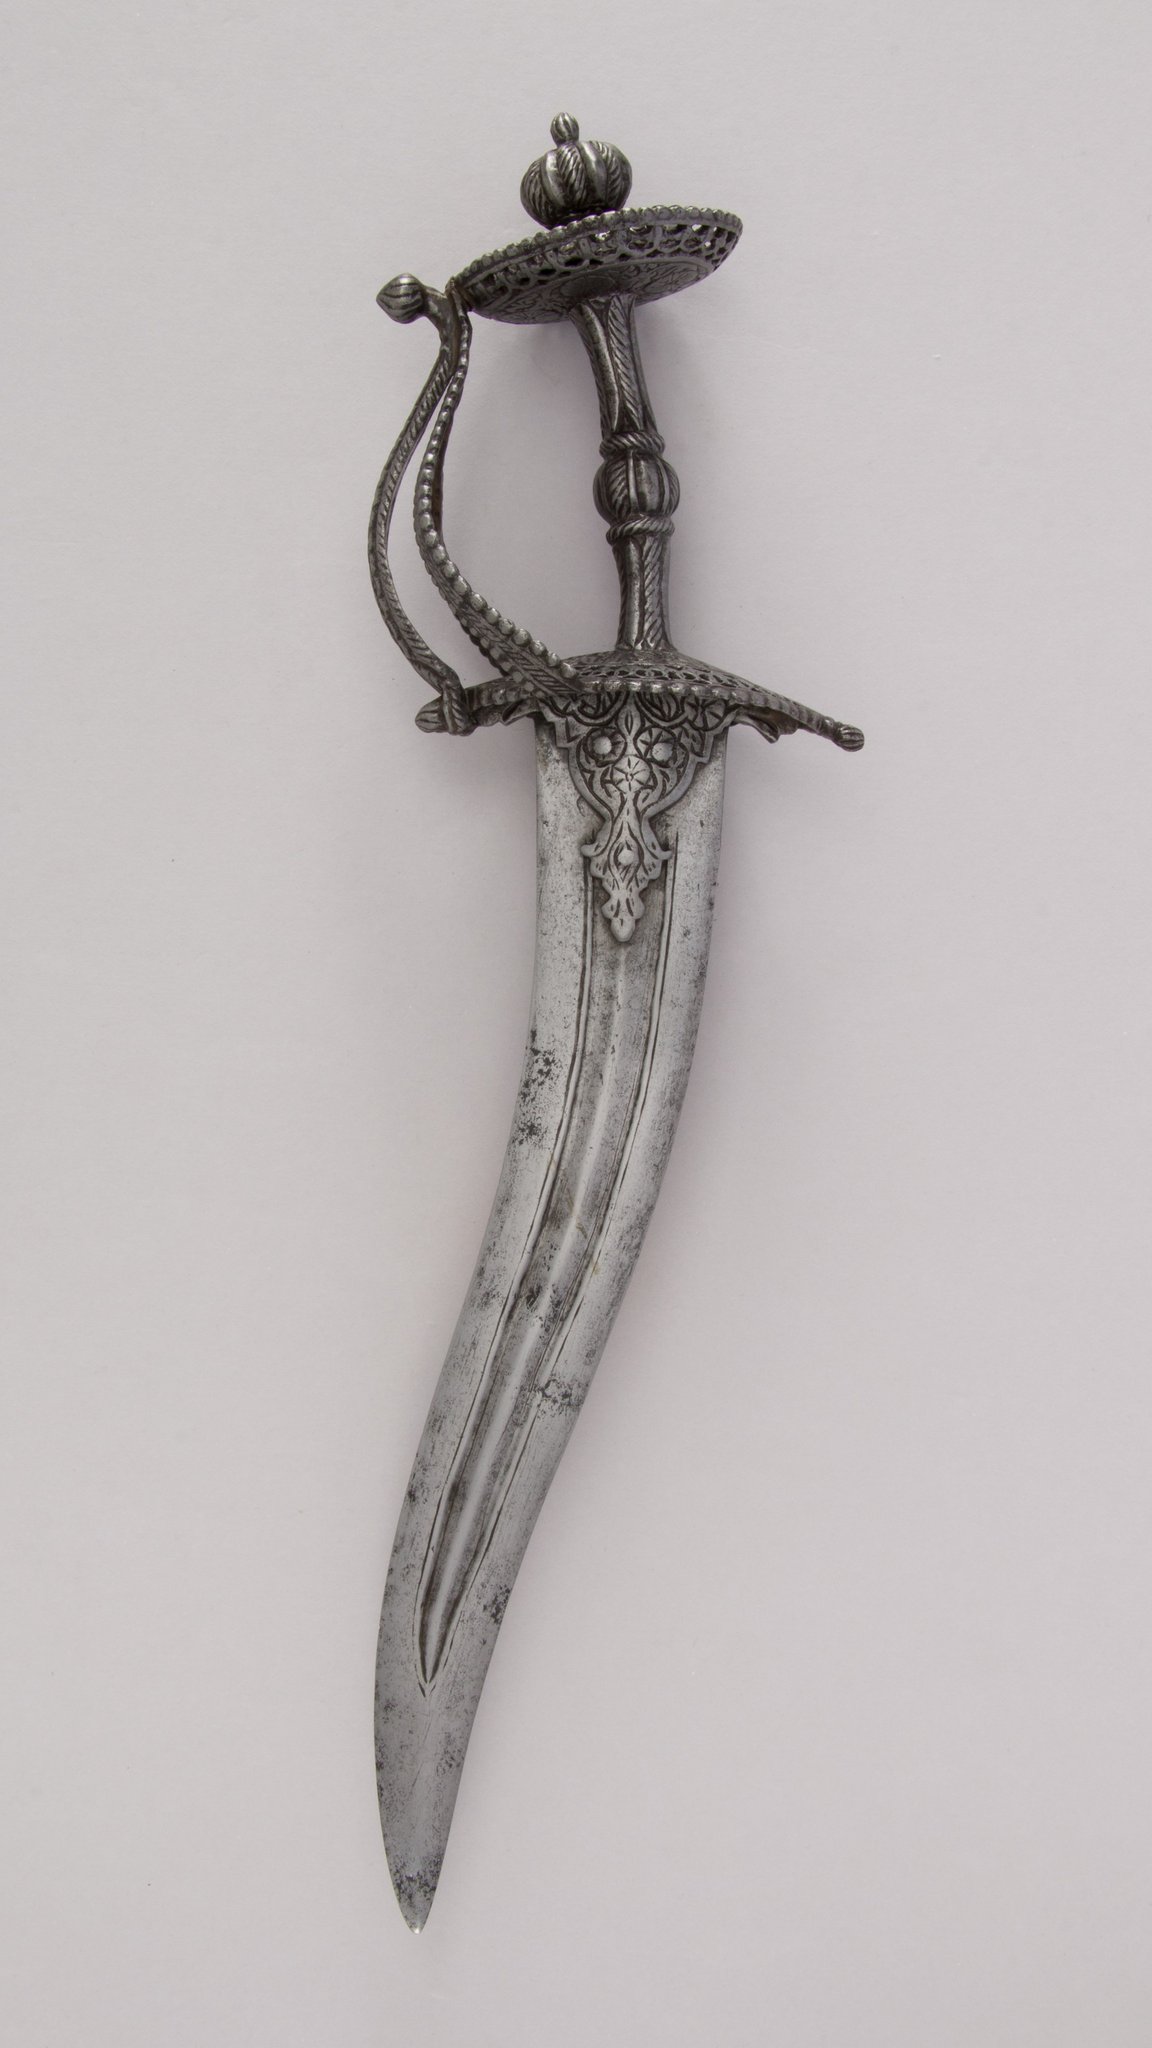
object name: dagger chilanum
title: Dagger (Chilanum)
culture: south indian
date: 1601-1700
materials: steel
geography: south india